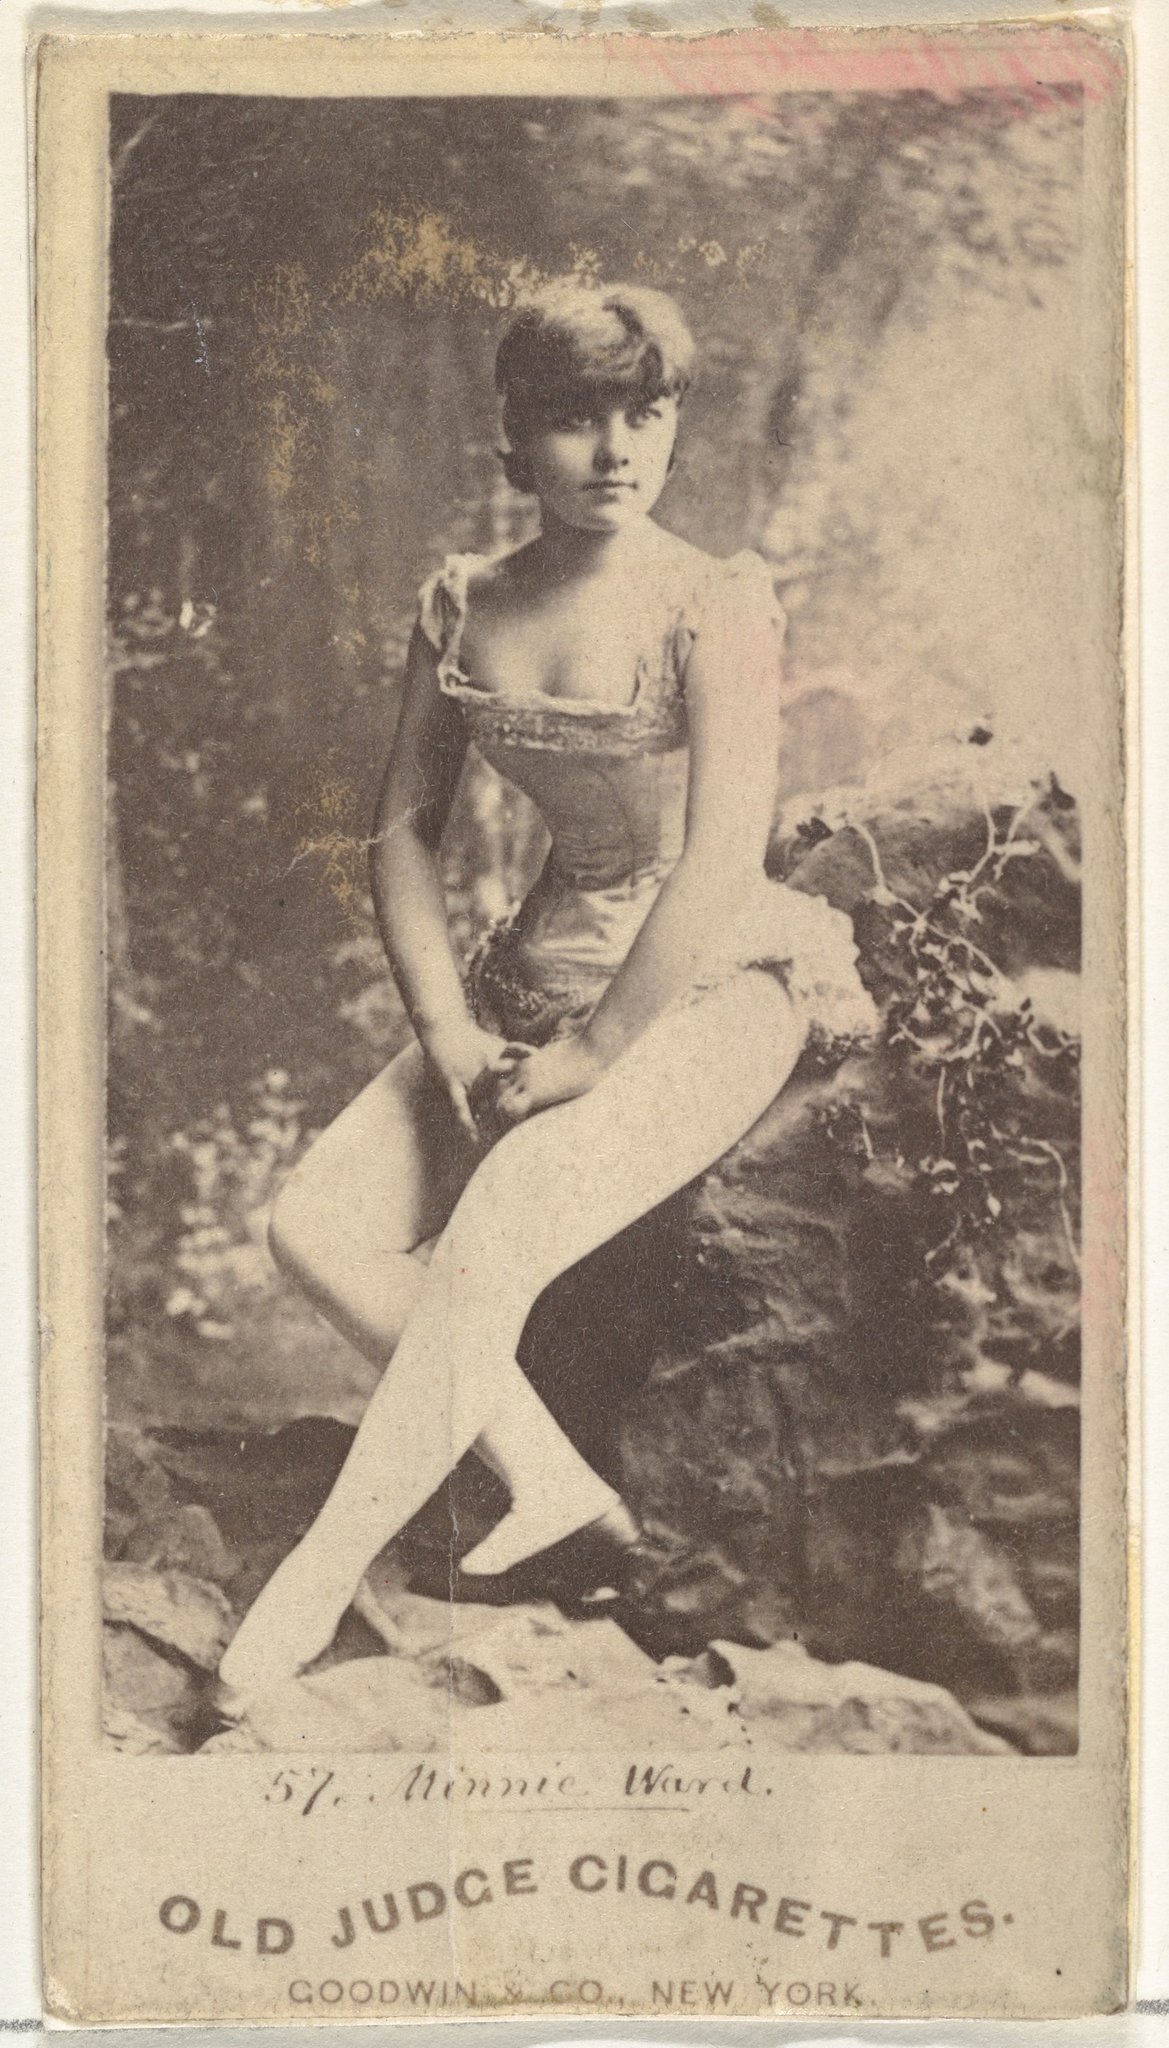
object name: photograph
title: Minnie Ward, from the Actors and Actresses series (N171) for Old Judge Cigarettes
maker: goodwin & company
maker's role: publisher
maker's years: 1850-1950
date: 1886-1890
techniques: albumen silver print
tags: portraits,women,actresses